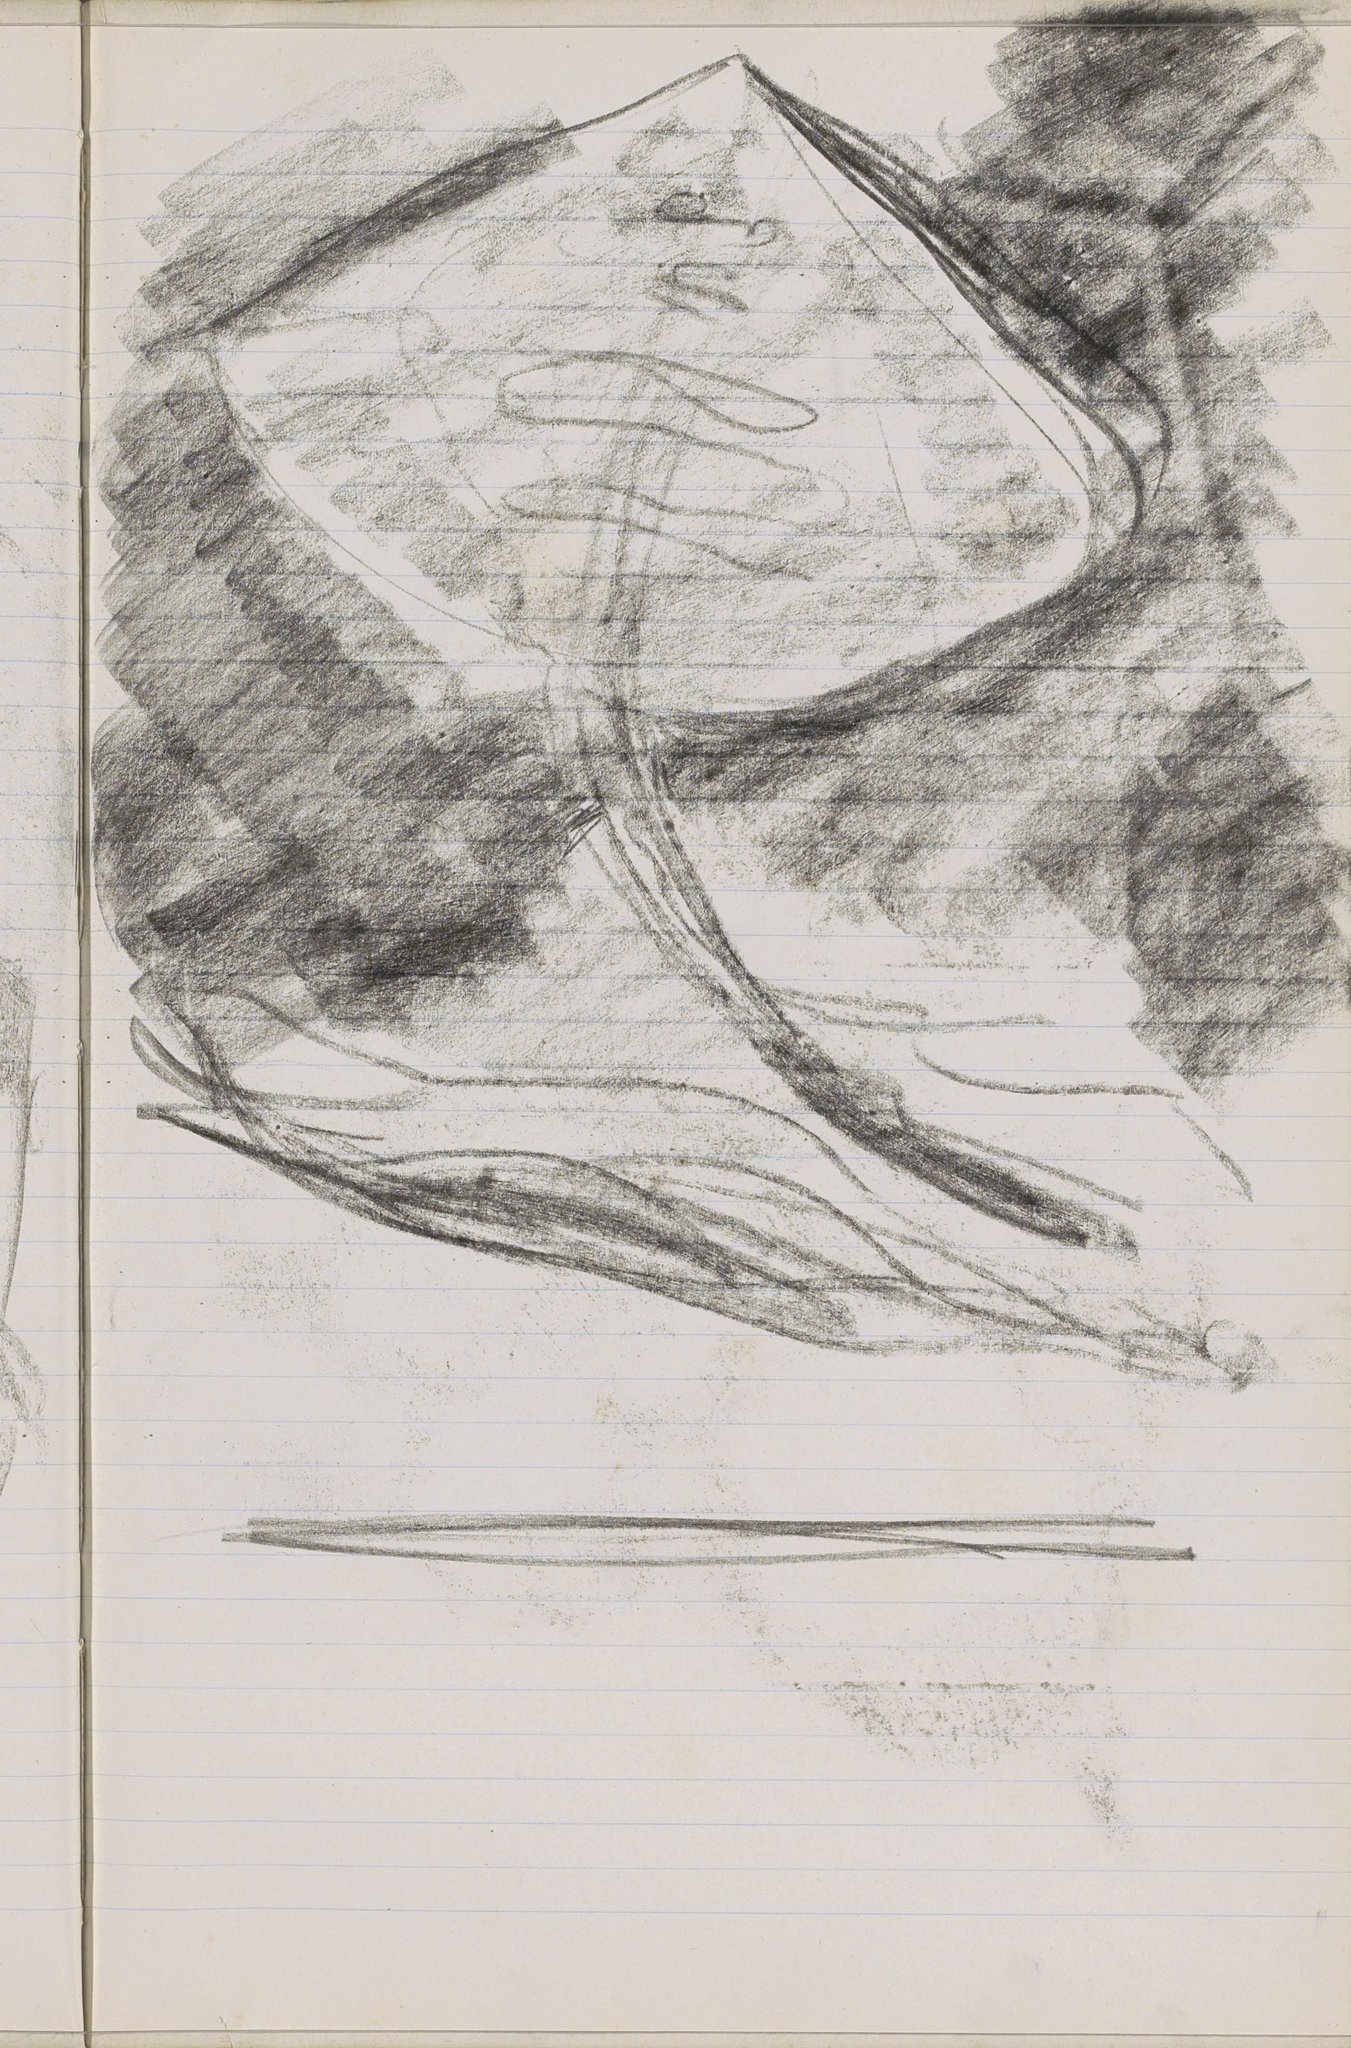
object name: sketchbook leaf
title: Pijlstaartrog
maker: gerrit willem dijsselhof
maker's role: designer, draughtsman, print maker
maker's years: 1866-1924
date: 1901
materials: chalk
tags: cartilaginous fishes: sting-ray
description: Blad 73 recto uit een schetsboek met 79 bladen.